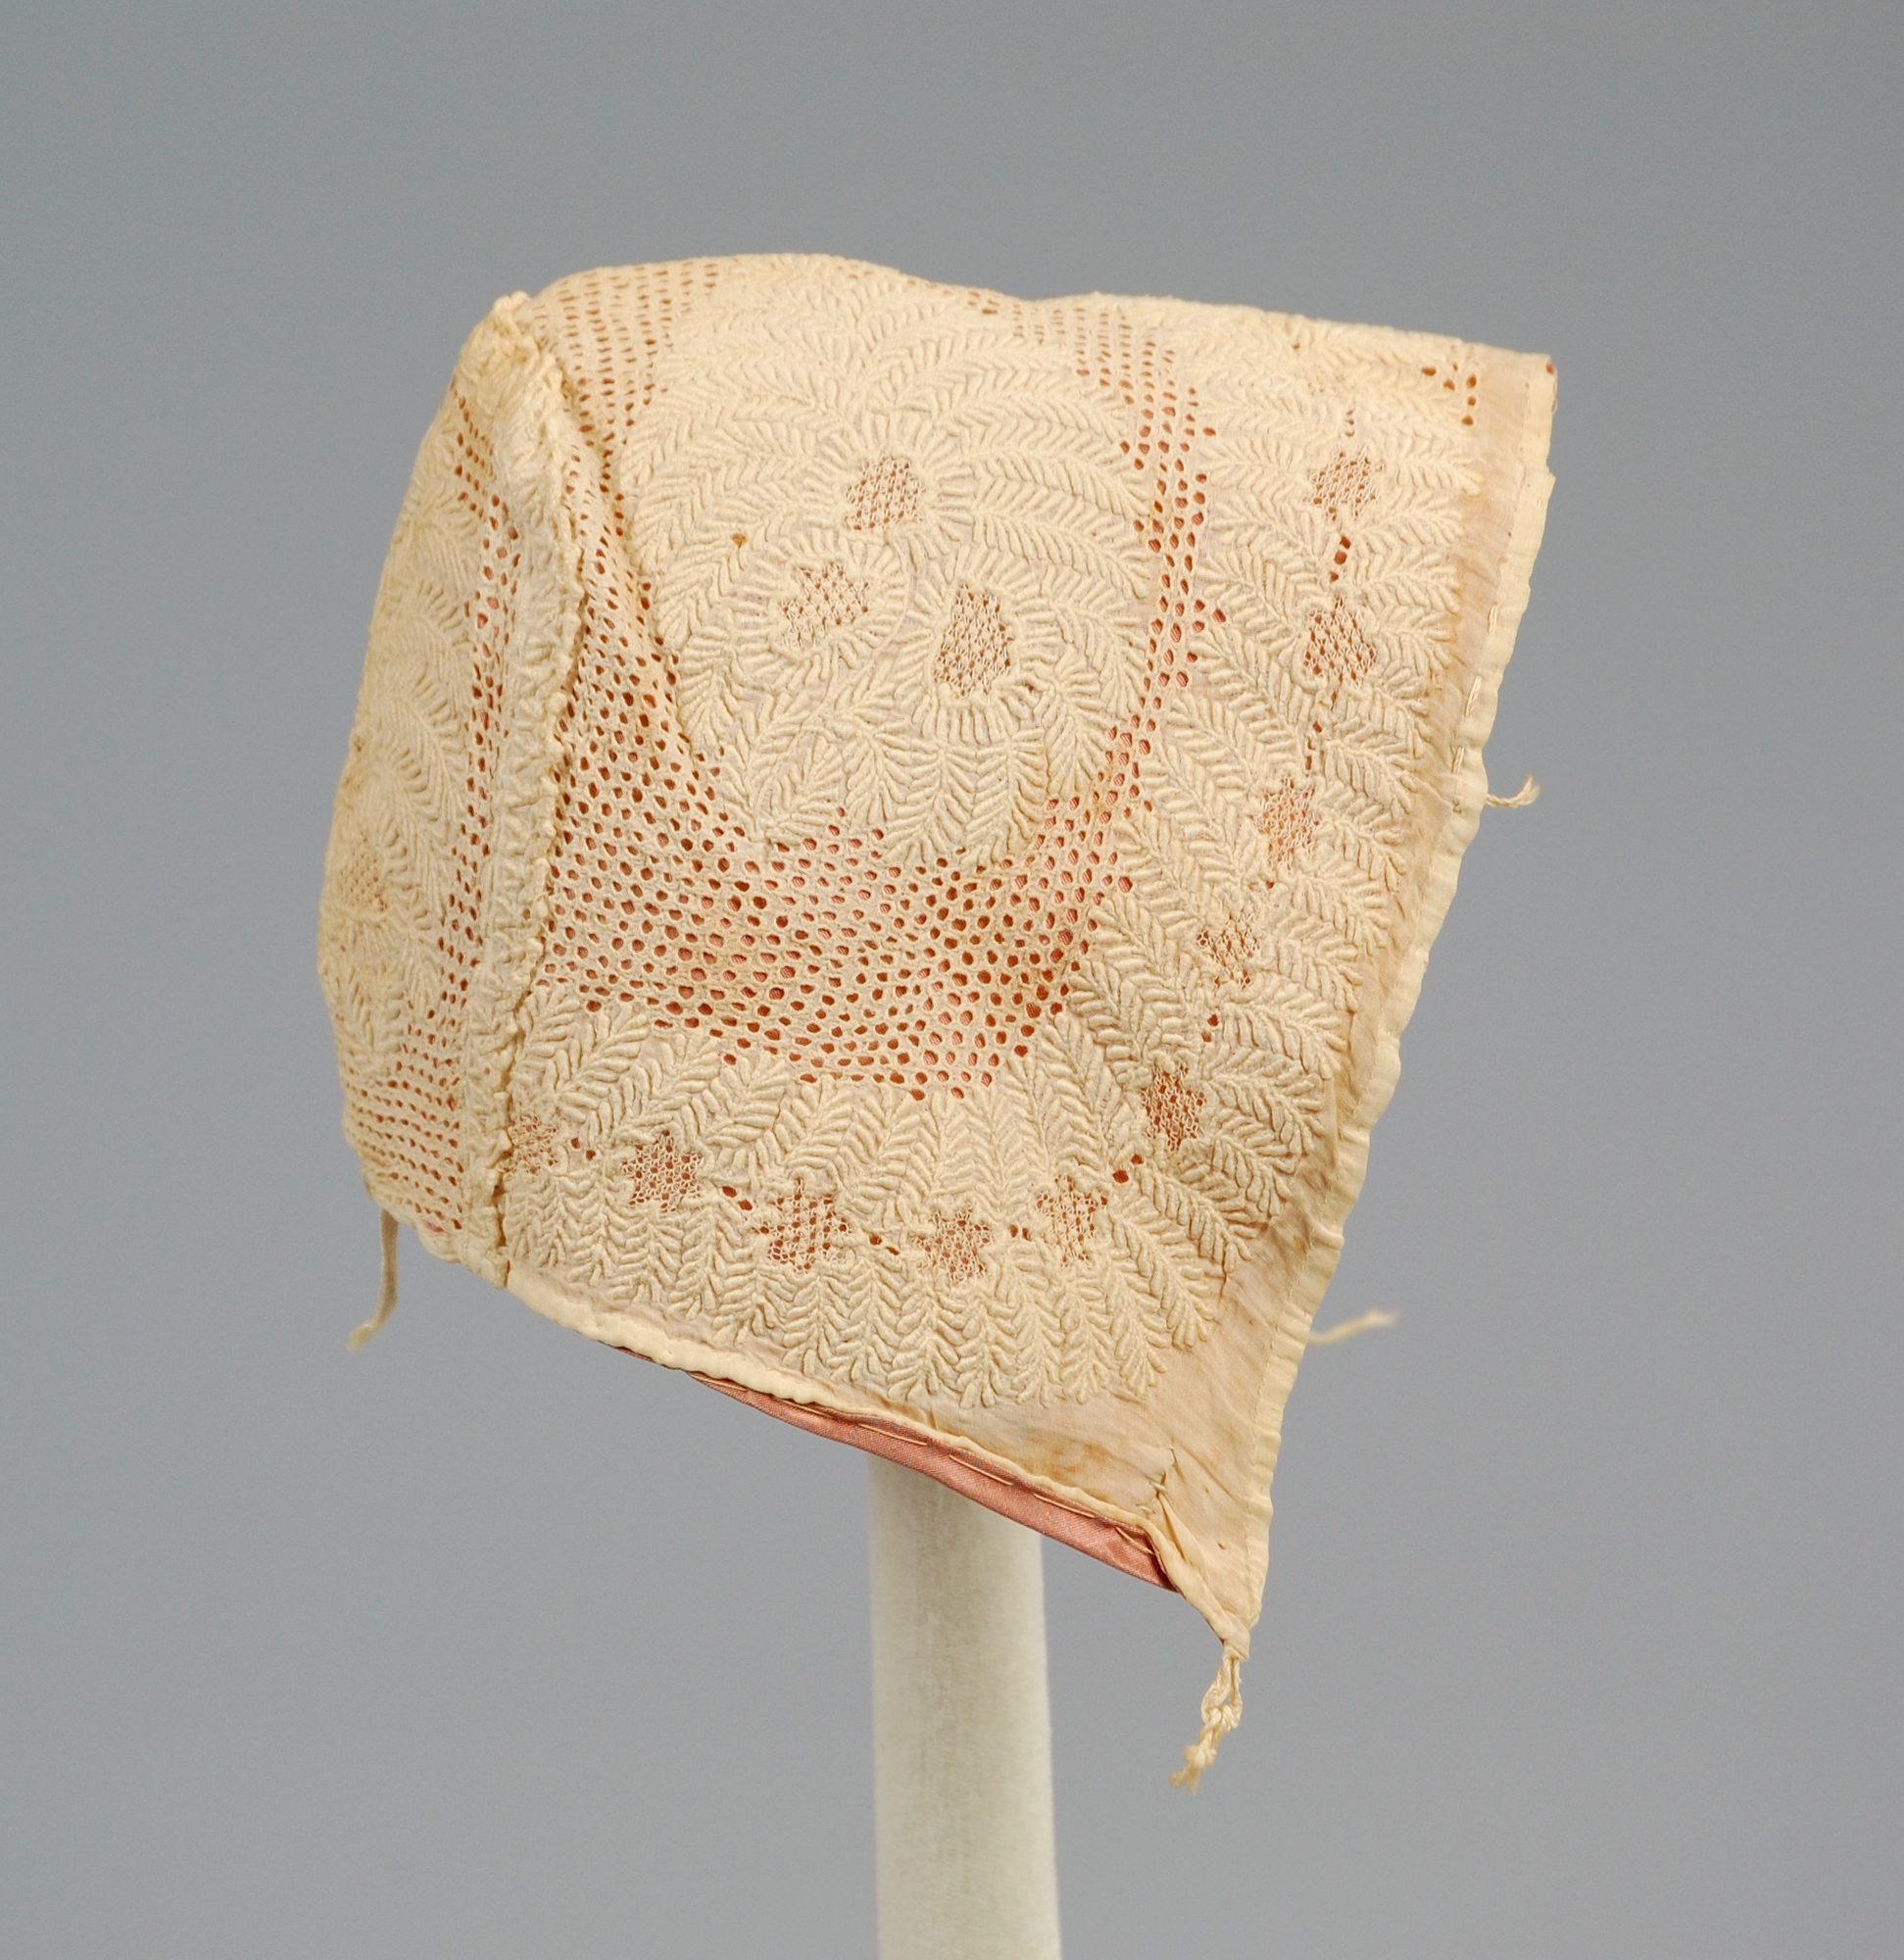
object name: cap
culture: american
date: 1820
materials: cotton, silk